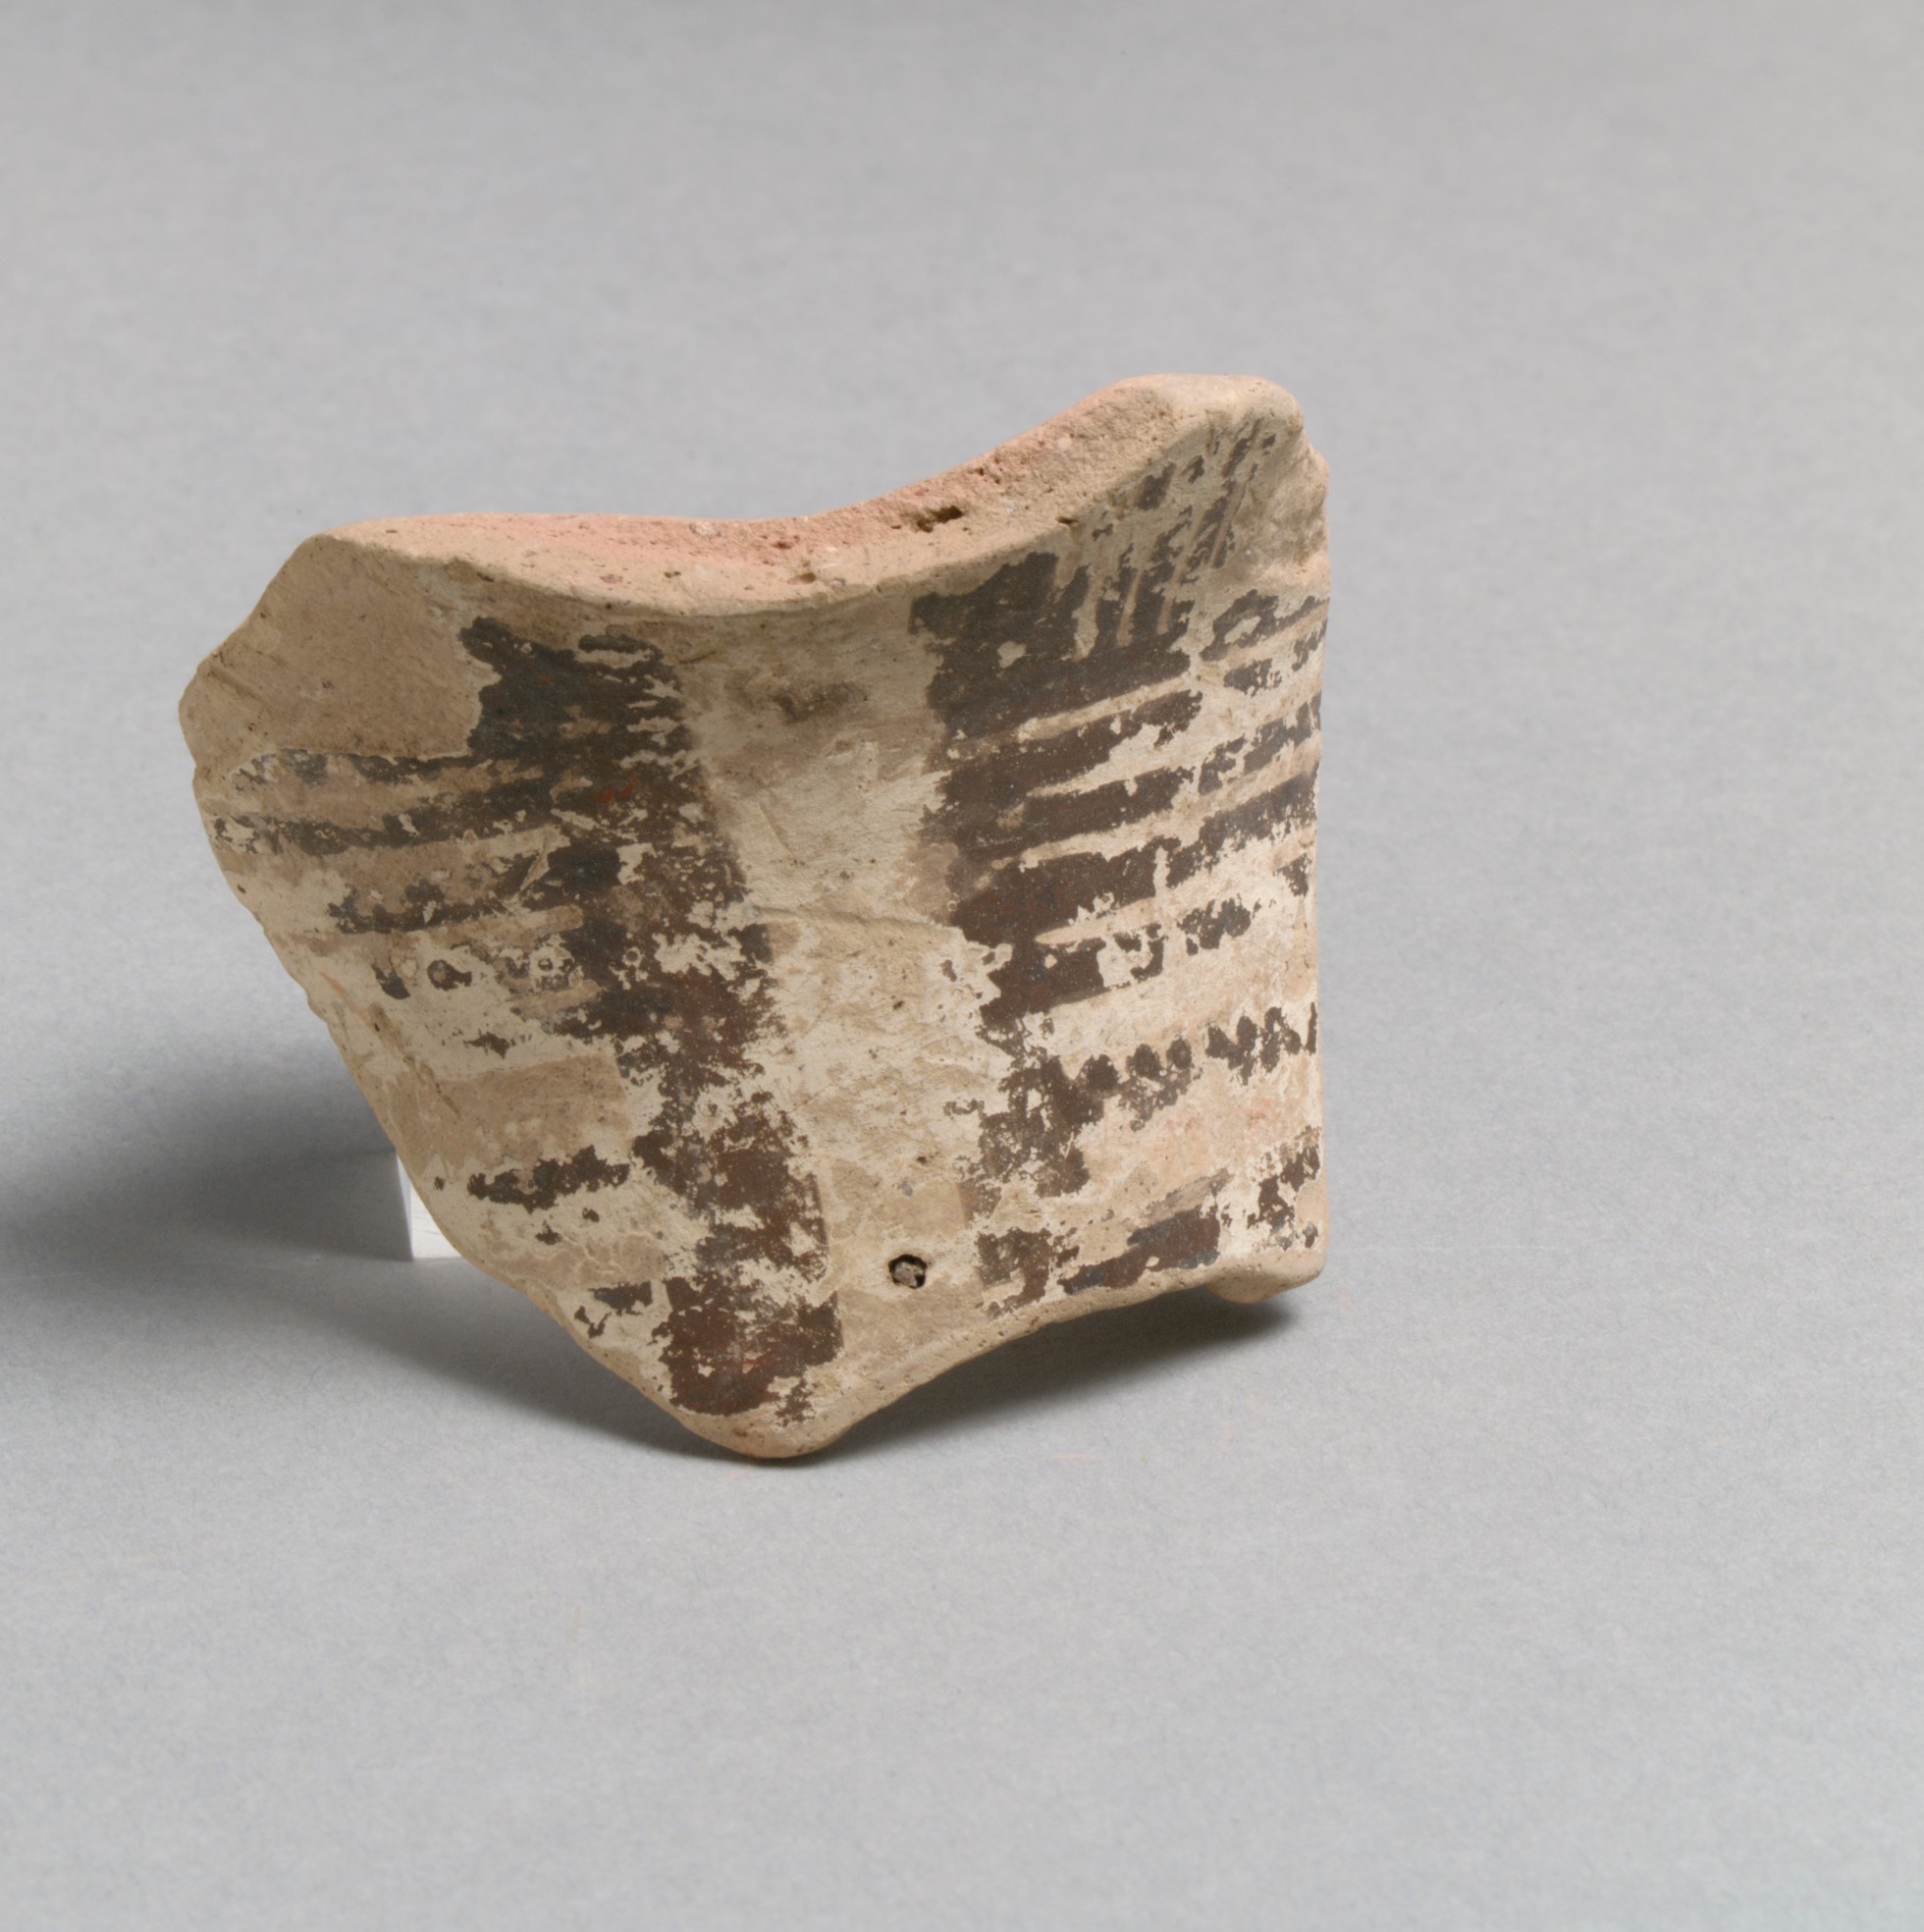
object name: vase fragment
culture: greek, laconian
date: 1050-700 BCE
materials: terracotta